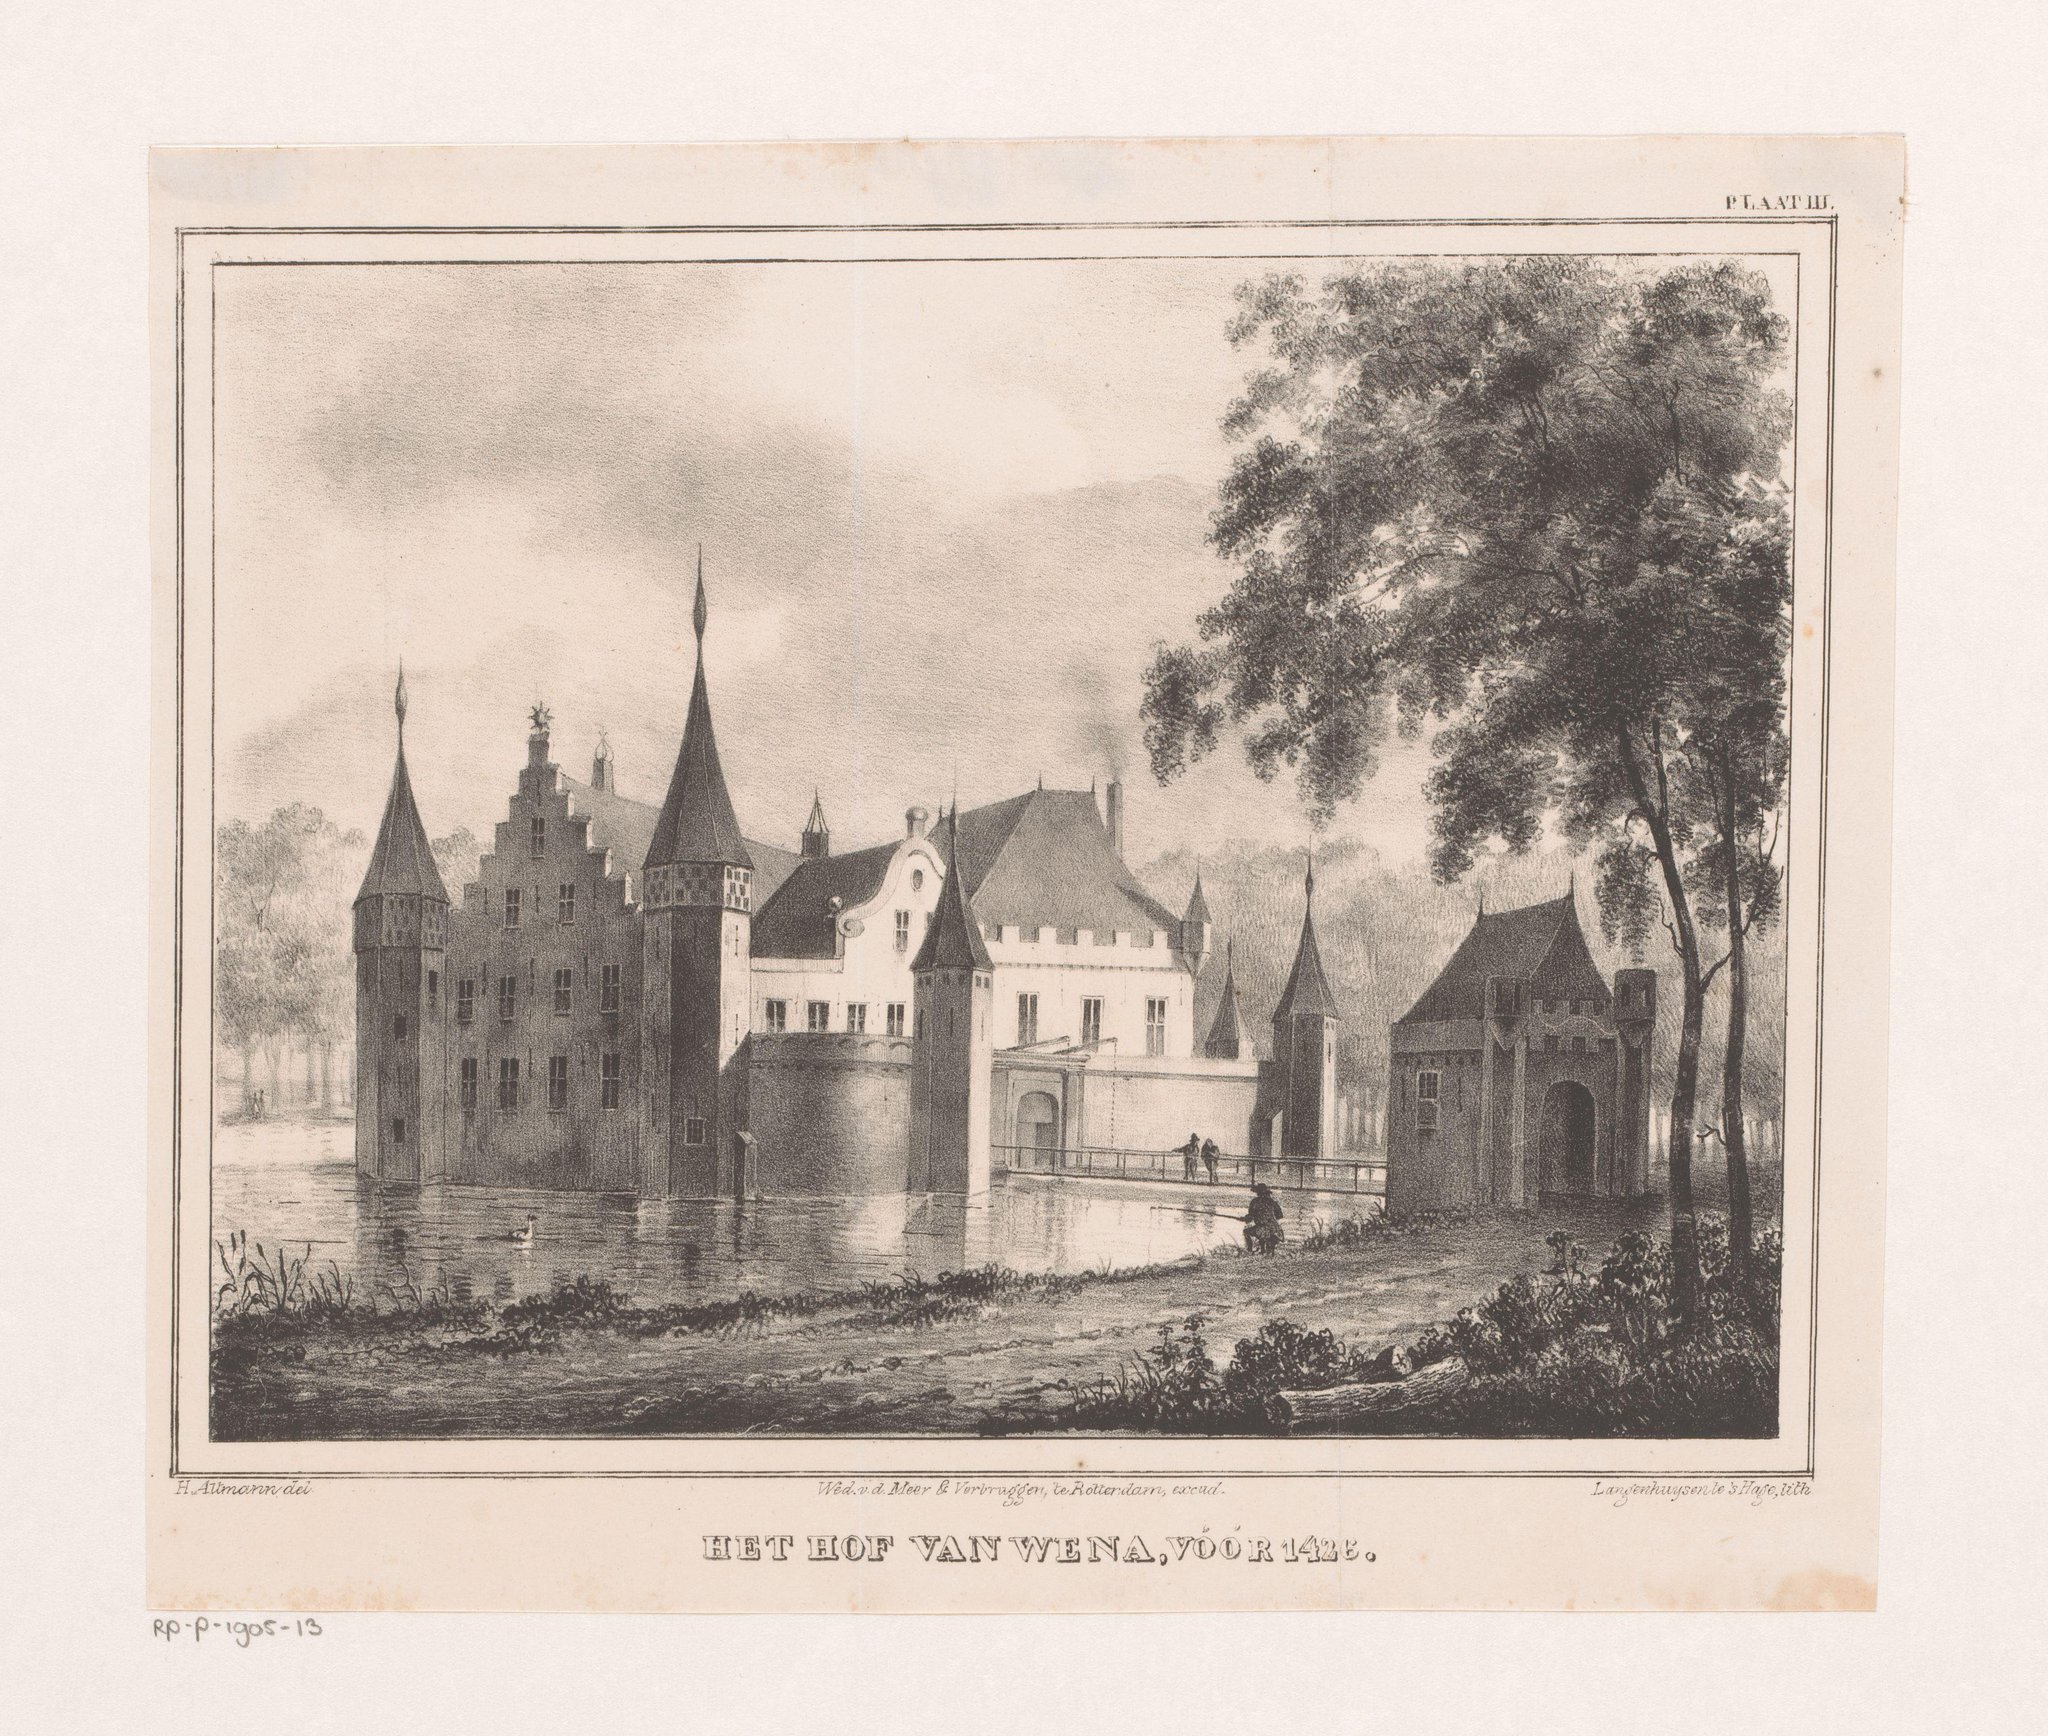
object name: print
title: Het hof van Wena, vóór 1426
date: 1830-1863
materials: paper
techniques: lithograph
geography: rotterdam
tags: landscape with tower or castle, rotterdam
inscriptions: collector's mark: Lugt 2228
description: Mogelijk werd deze prent uitgegeven in: Reyn, G. van Geschiedkundige beschrijving der stad Rotterdam; en beknopt overzicht van het hoogheemraadschap van Schieland. Rotterdam: Wed. van der Meer & Verbruggen, 1832.